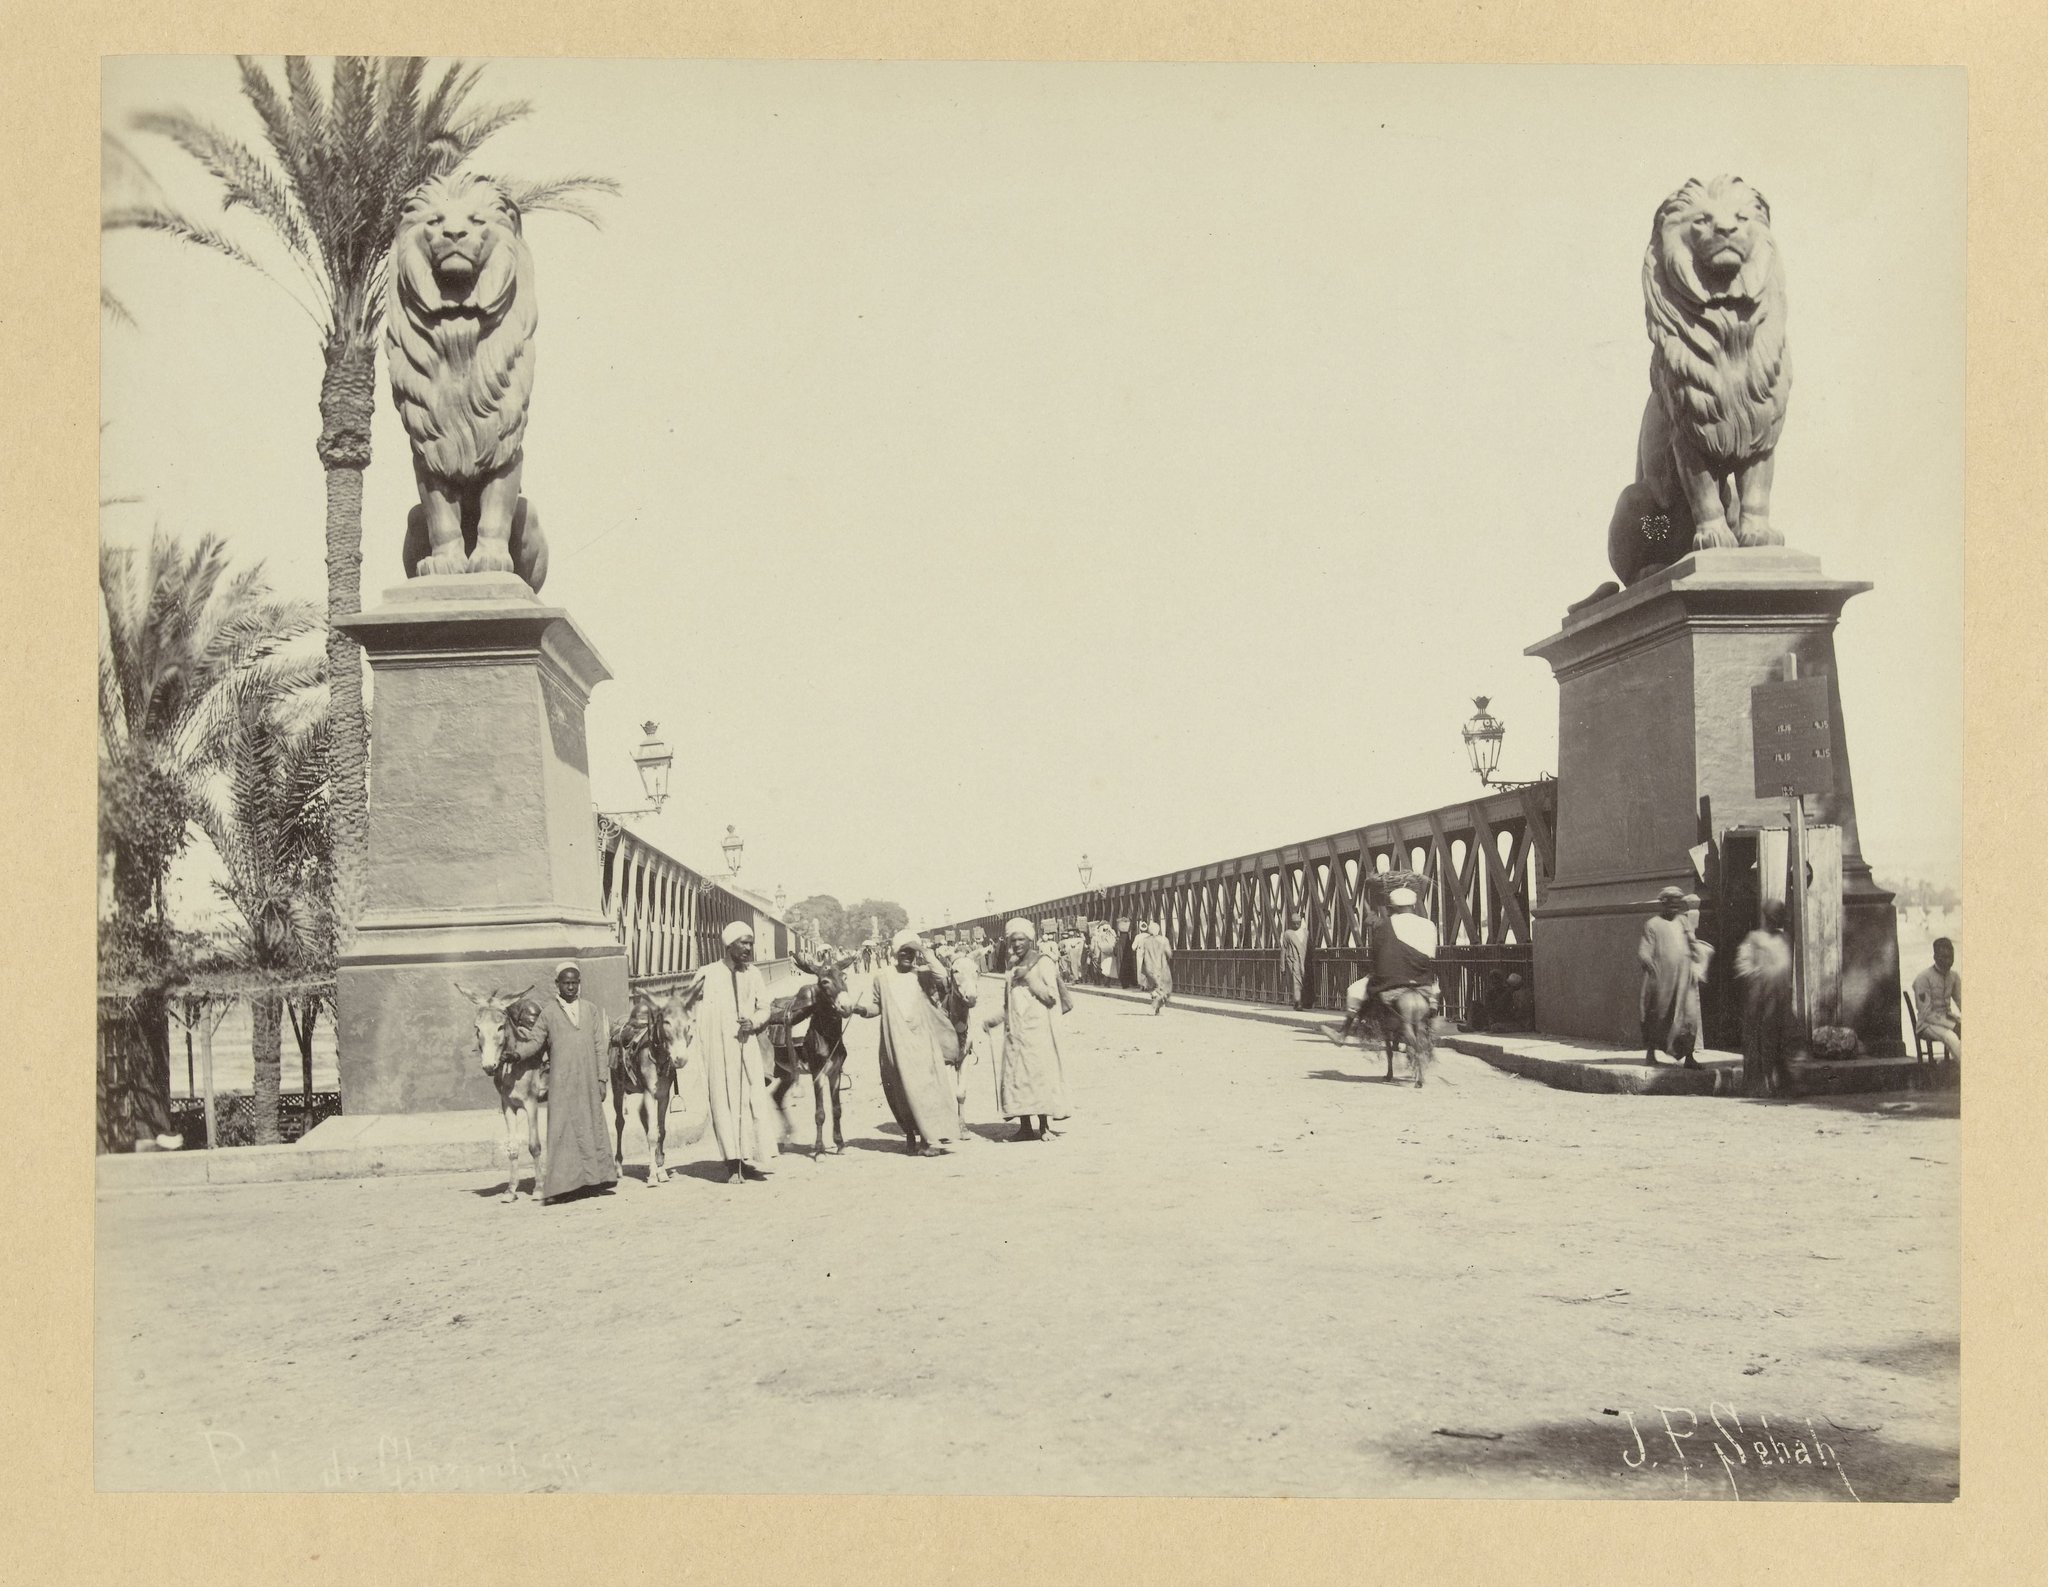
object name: photograph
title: E 6. Kasr el Nil (Nijlbrug). Caïro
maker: jean pascal sébah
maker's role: fotograaf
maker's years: 1872-1947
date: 1888-1895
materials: cardboard, paper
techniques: albumen print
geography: cairo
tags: piece of sculpture, reproduction of a piece of sculpture, bridge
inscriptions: check stamp: ‘Bristol/ L.M.’, stamp: ‘Gemeentelijke bibliotheek/ Rotterdam’, number: ‘911’, title: ‘E 6. Kasr el Nil. (Nijlbrug). Caïro.’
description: Onderdeel van een groep door fotograaf Richard Polak op reis verzamelde foto’s. Deze foto is samen met andere op zijn reizen verzamelde foto's tentoongesteld bij de Rotterdamsche Kunstkring (1895), Arti en Amicitiae te Amsterdam (1897-1898?) en Societeit 't Collegie te Kampen (datum vooralsnog onbekend).